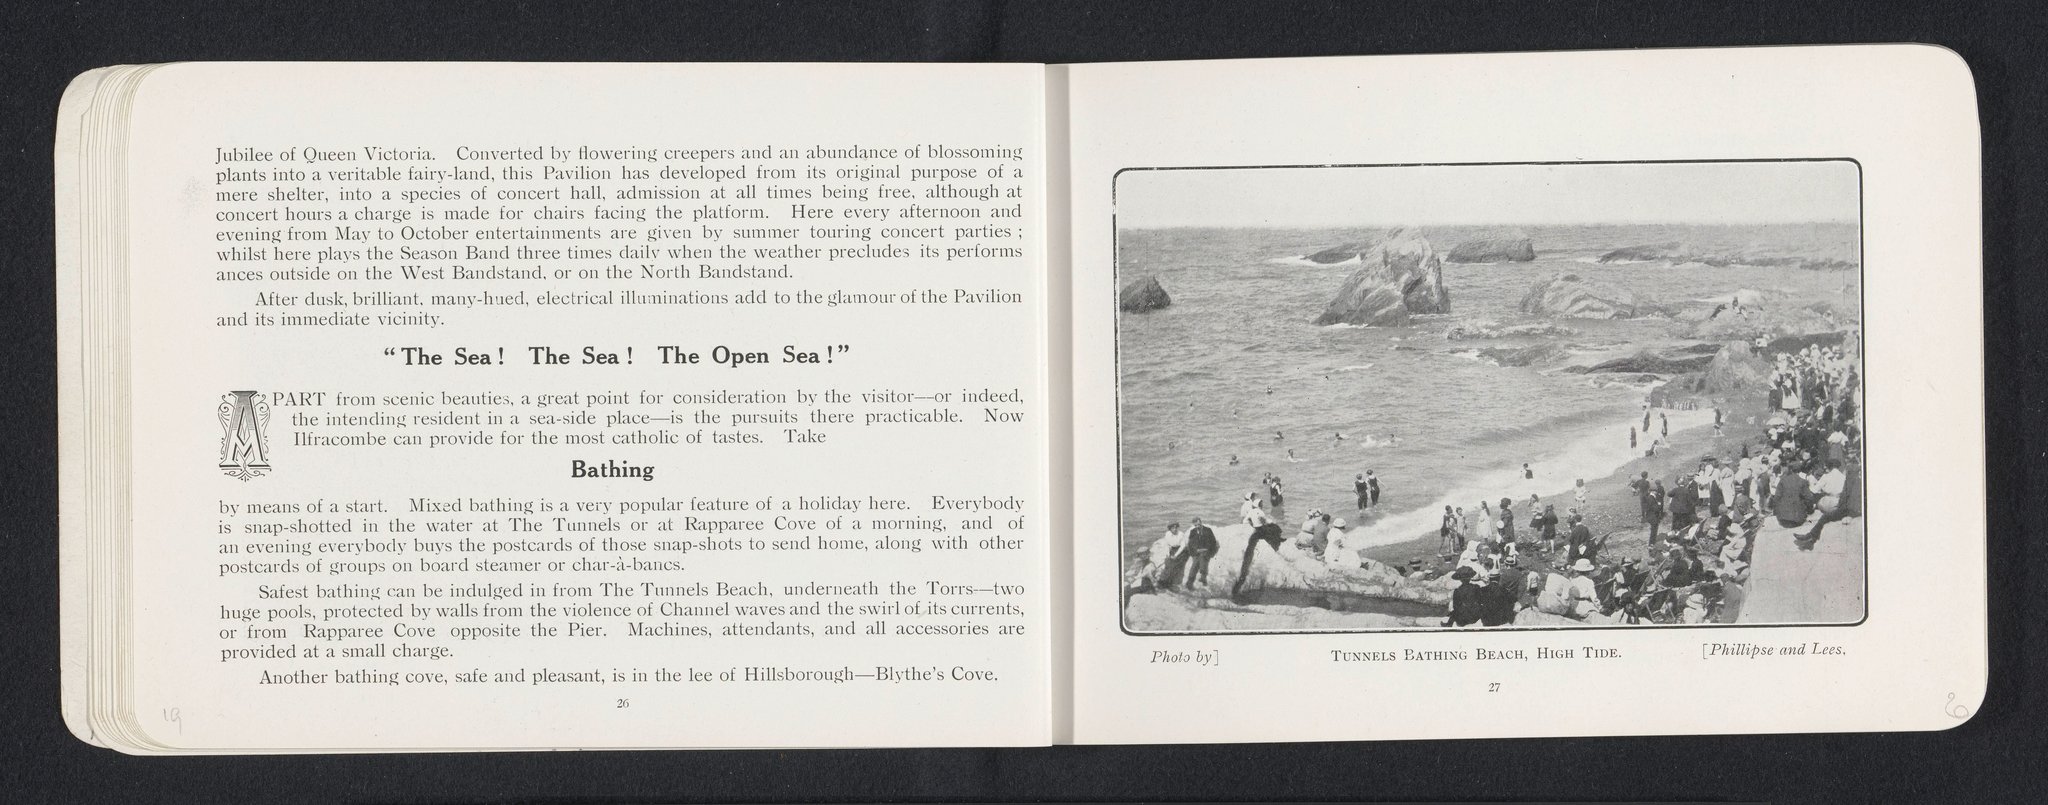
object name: page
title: Tunnel Bathing Beach, high tide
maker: Anonymous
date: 1900-1920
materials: paper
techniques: autotype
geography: ilfracombe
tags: rocky coast, (high) hill